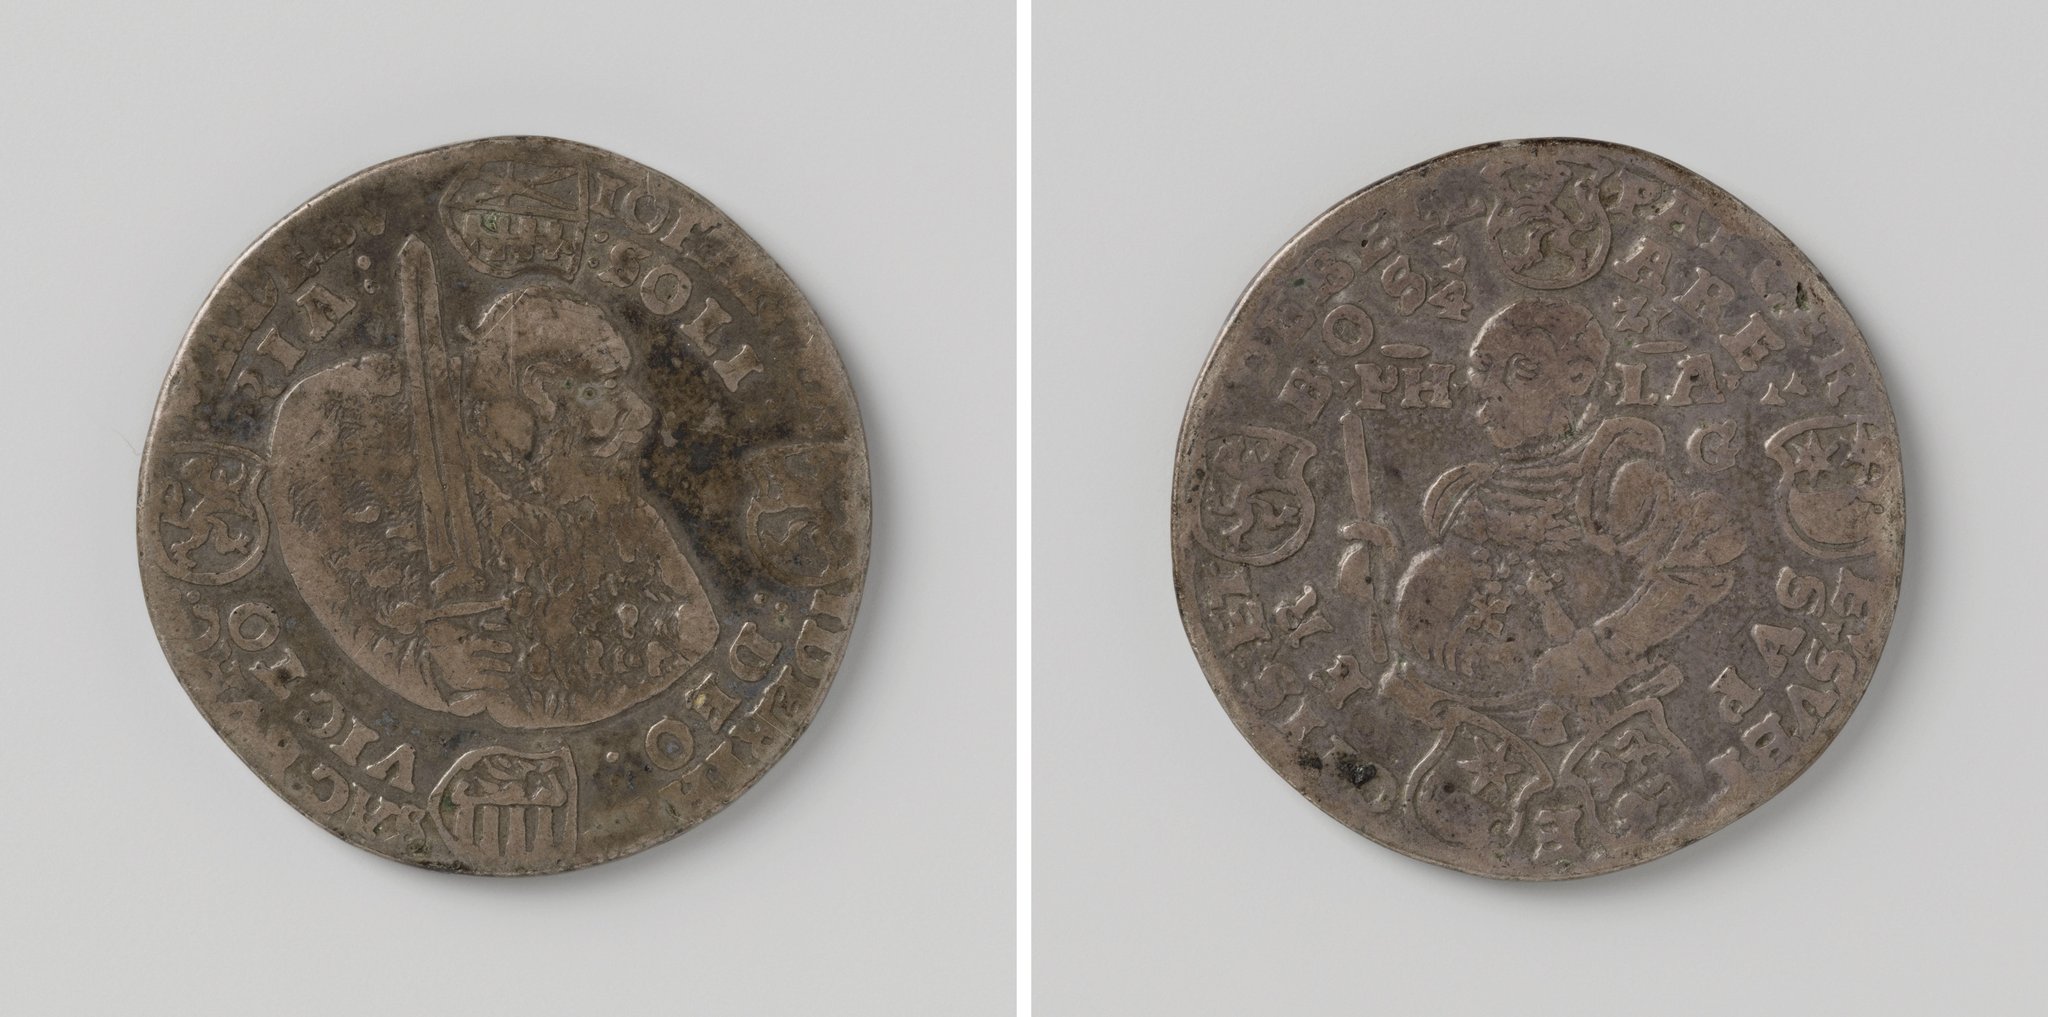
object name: history medal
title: Johan Frederik de Grootmoedige, keurvorst van Saksen en Filips de Grootmoedige, landgraaf van Hessen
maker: Anonymous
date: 1541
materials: silver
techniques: striking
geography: germany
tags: philip i (landgrave of hesse)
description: Zilveren penning. Voorzijde: borststuk man met zwaard op schouder binnen tweeregelig omschrift onderbroken door vier wapenschilden binnen omschrift. Keerzijde: borststuk man met commandostaf en hand op zwaard tussen opschrift binnen tweeregelig omschrift onderbroken door vijf wapenschilden binnen omschrift.